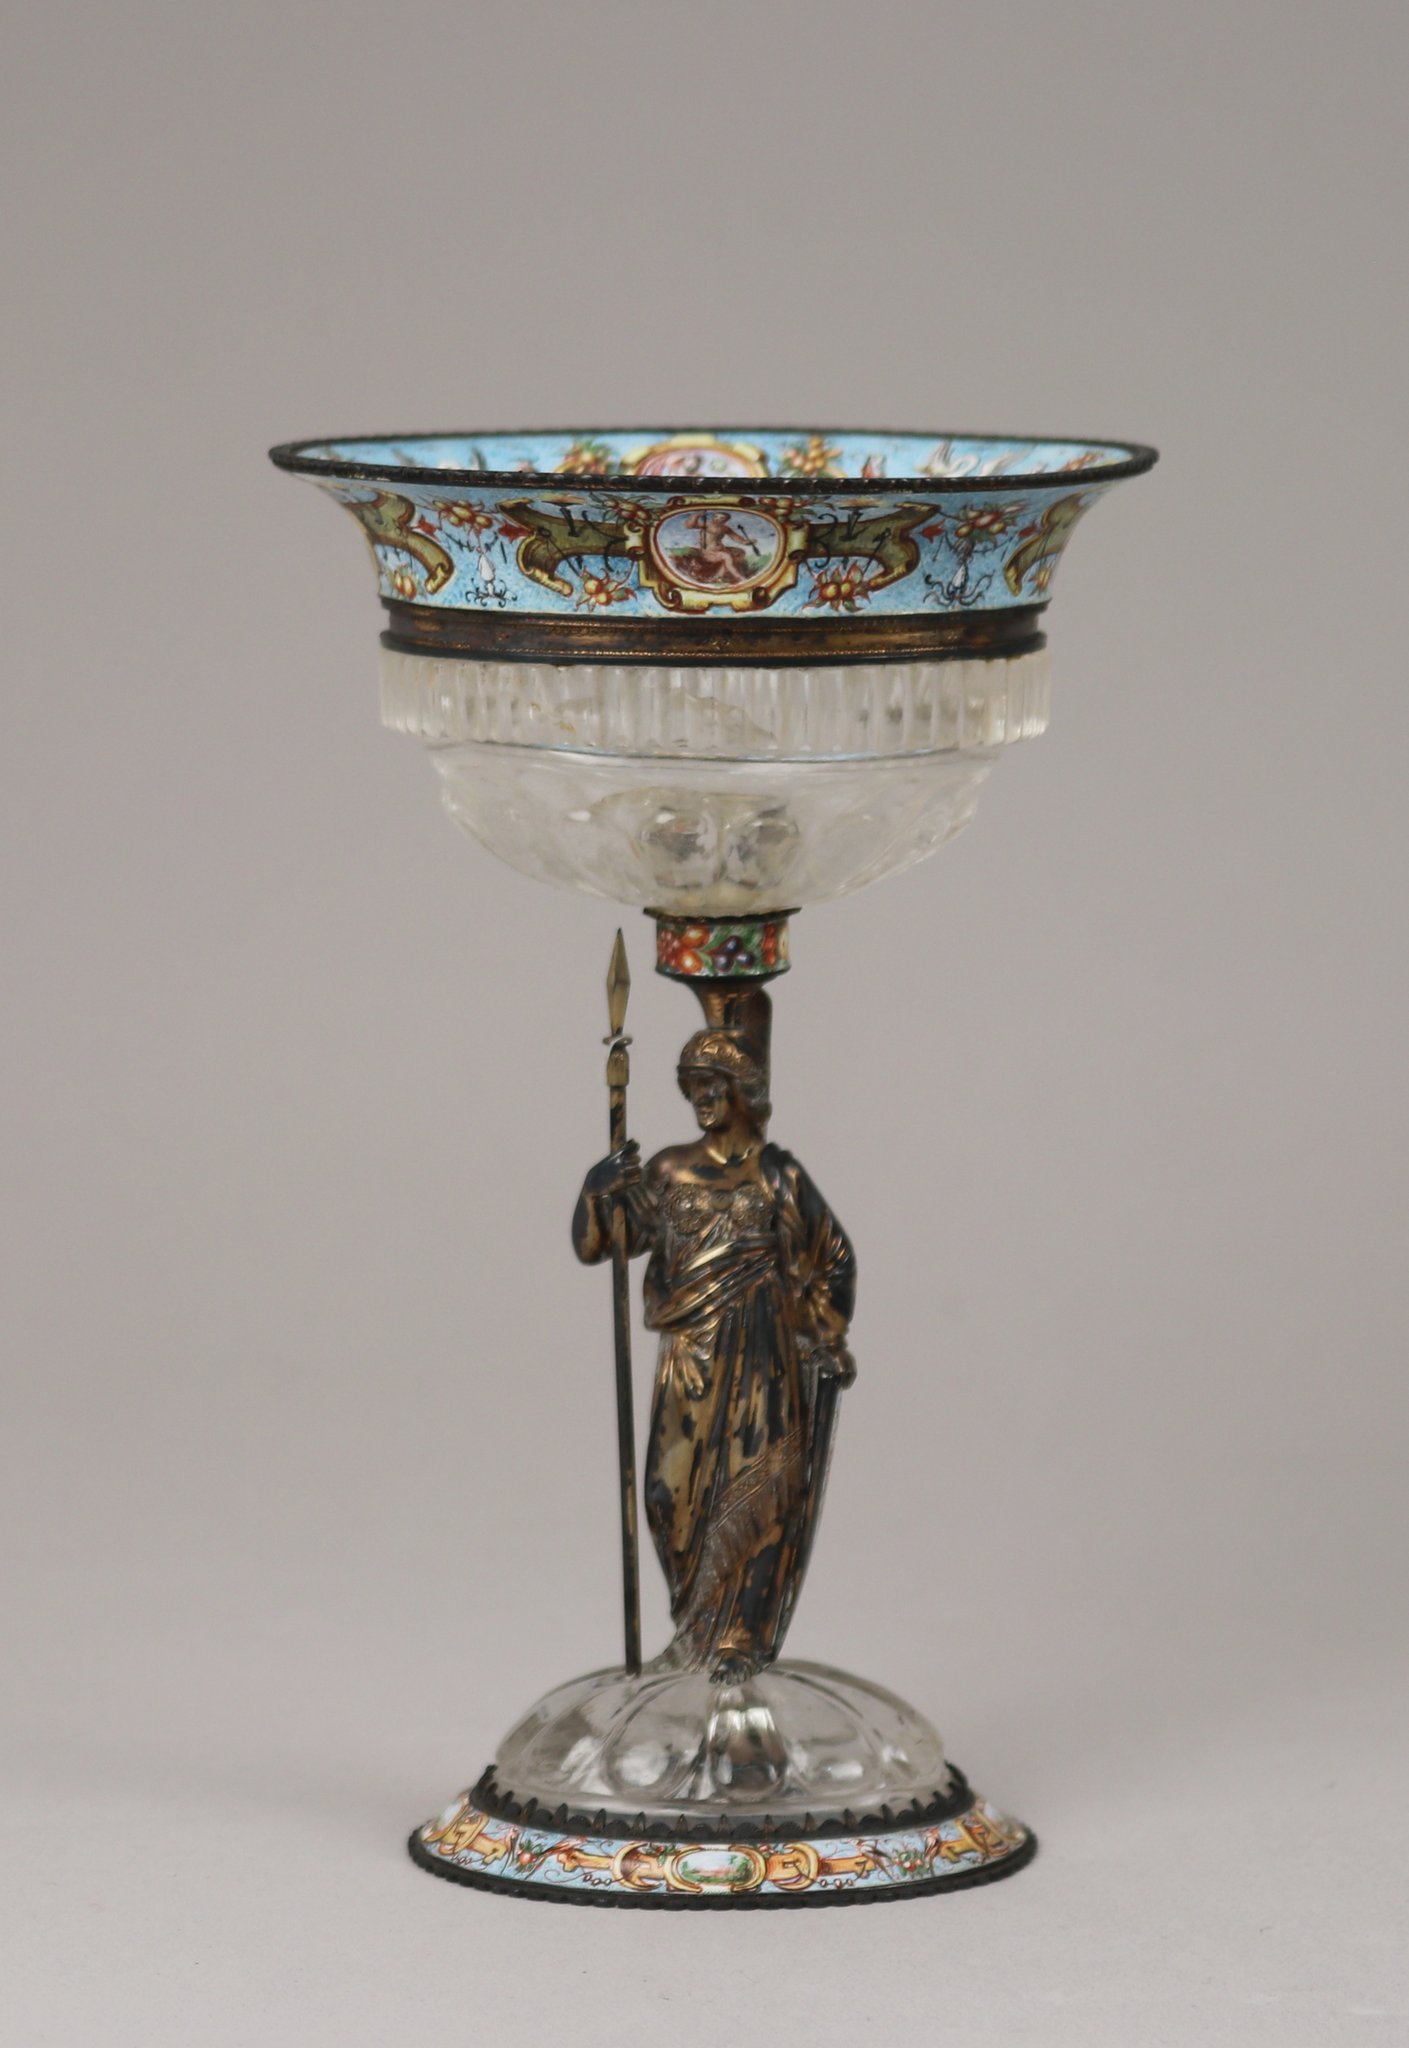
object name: standing cup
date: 1866-1880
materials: enamel, quartz, silver gilt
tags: birds,soldiers,spears